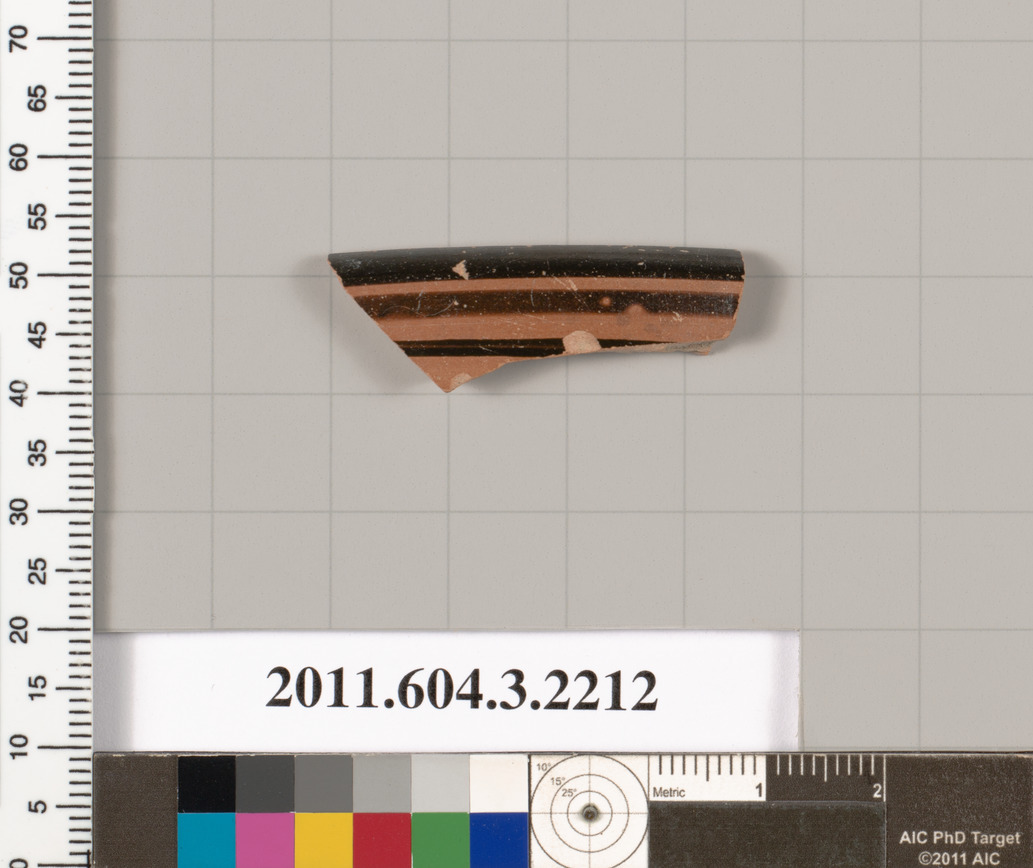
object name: kylix fragment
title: Terracotta fragment of a kylix (drinking cup)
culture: greek, attic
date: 600-401 BCE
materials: terracotta